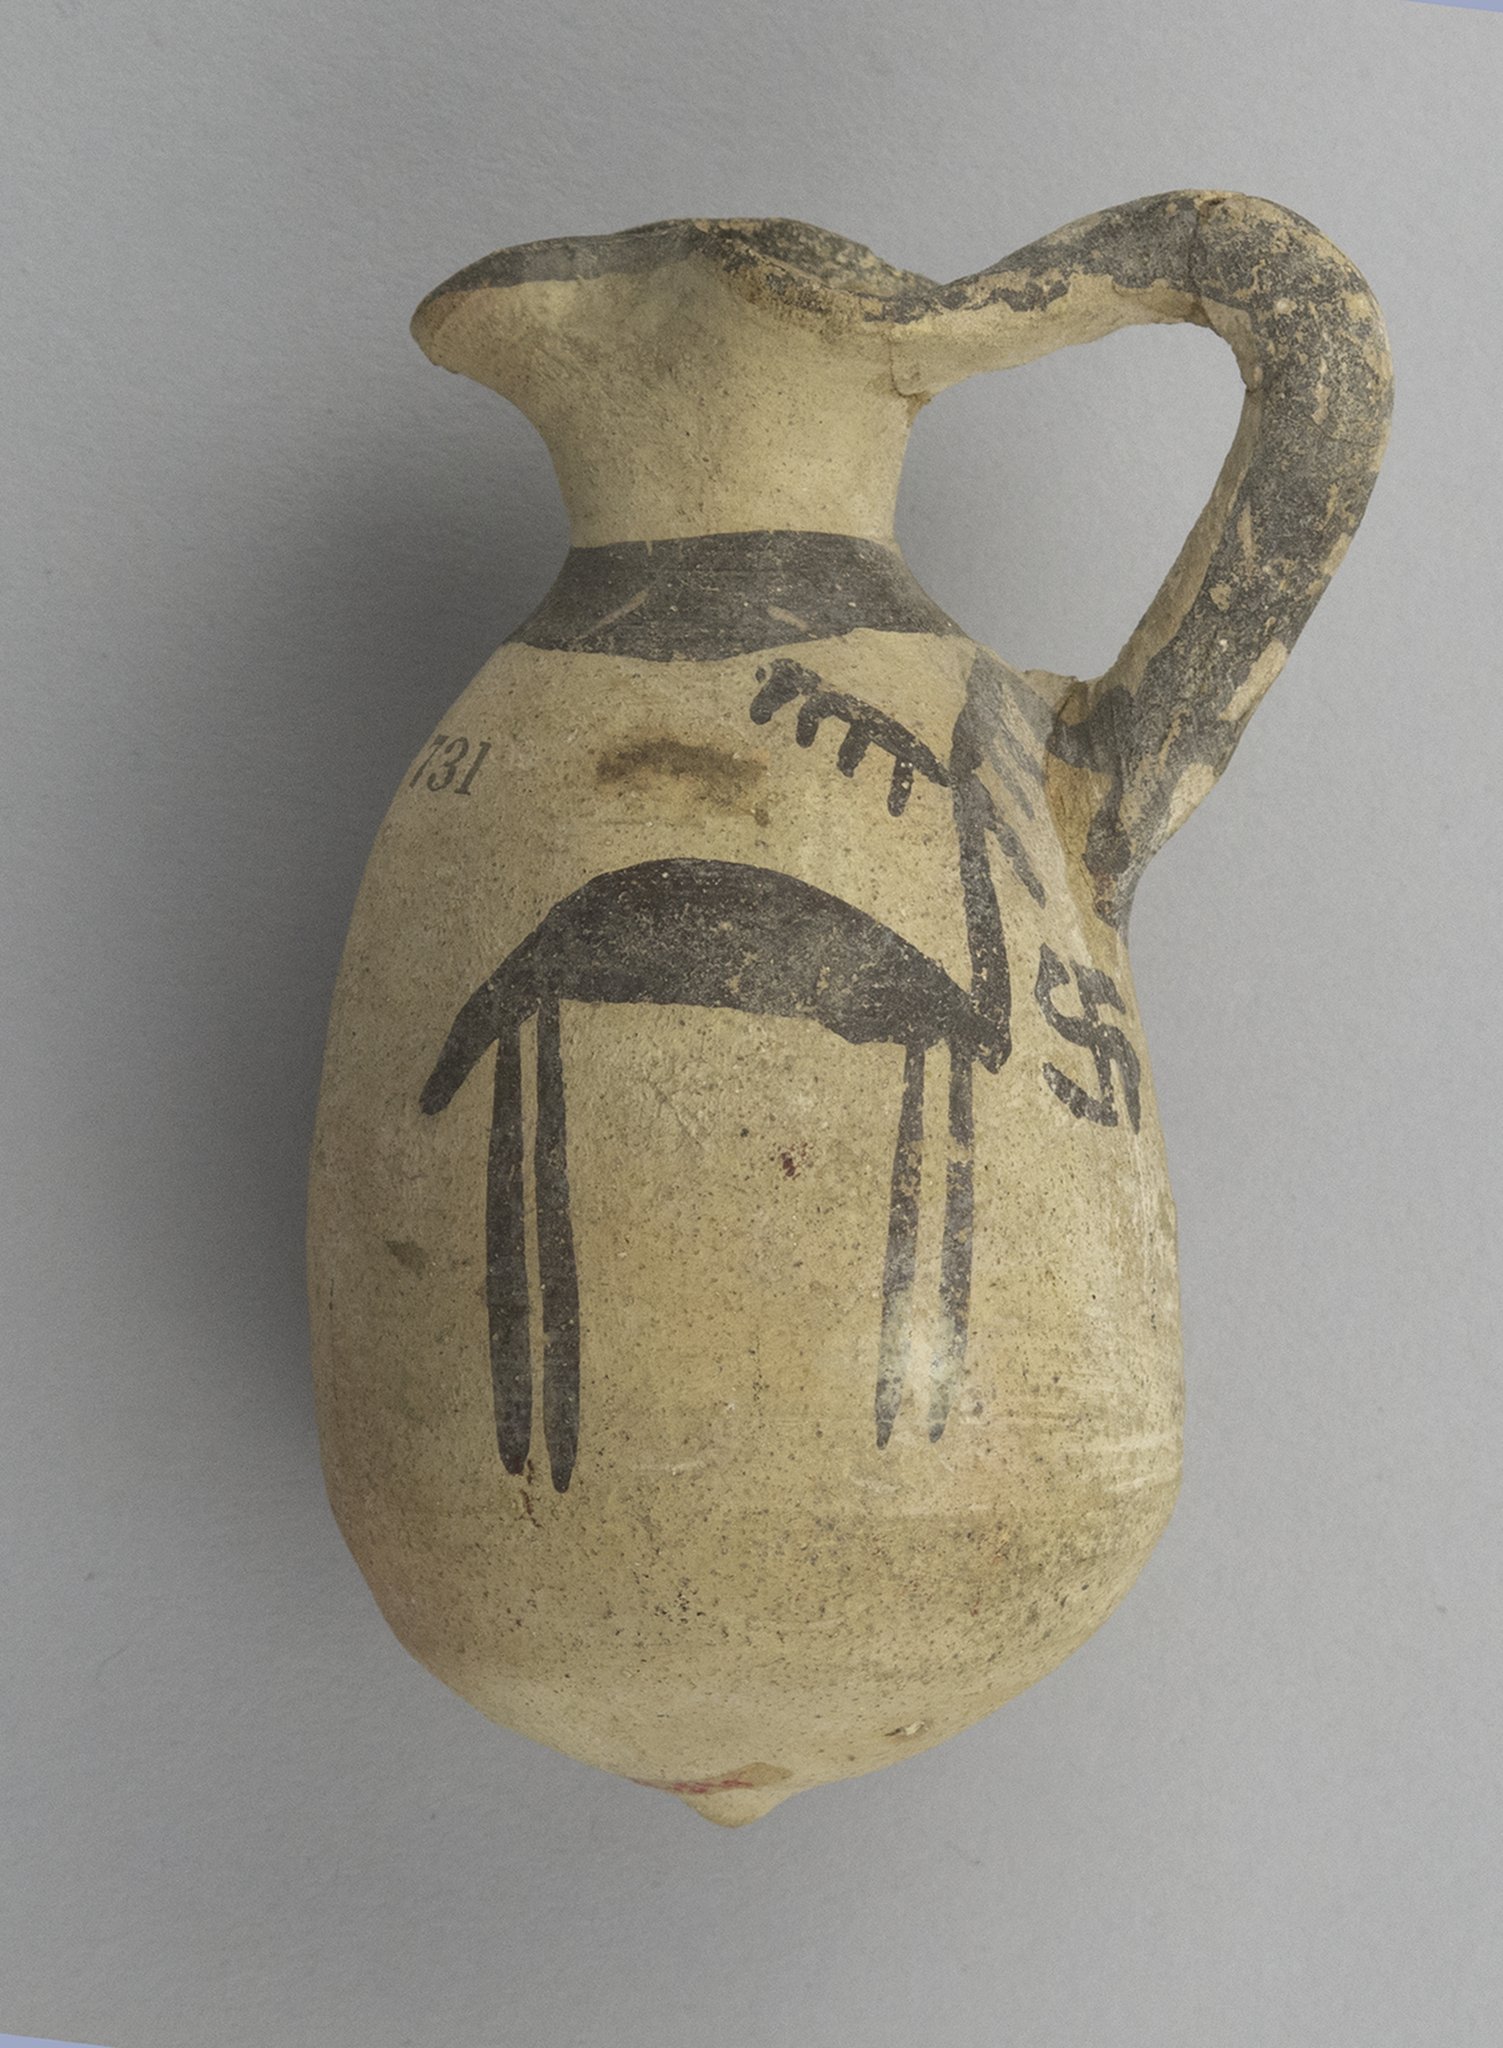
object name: jug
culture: cypriot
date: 850-750 BCE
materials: terracotta